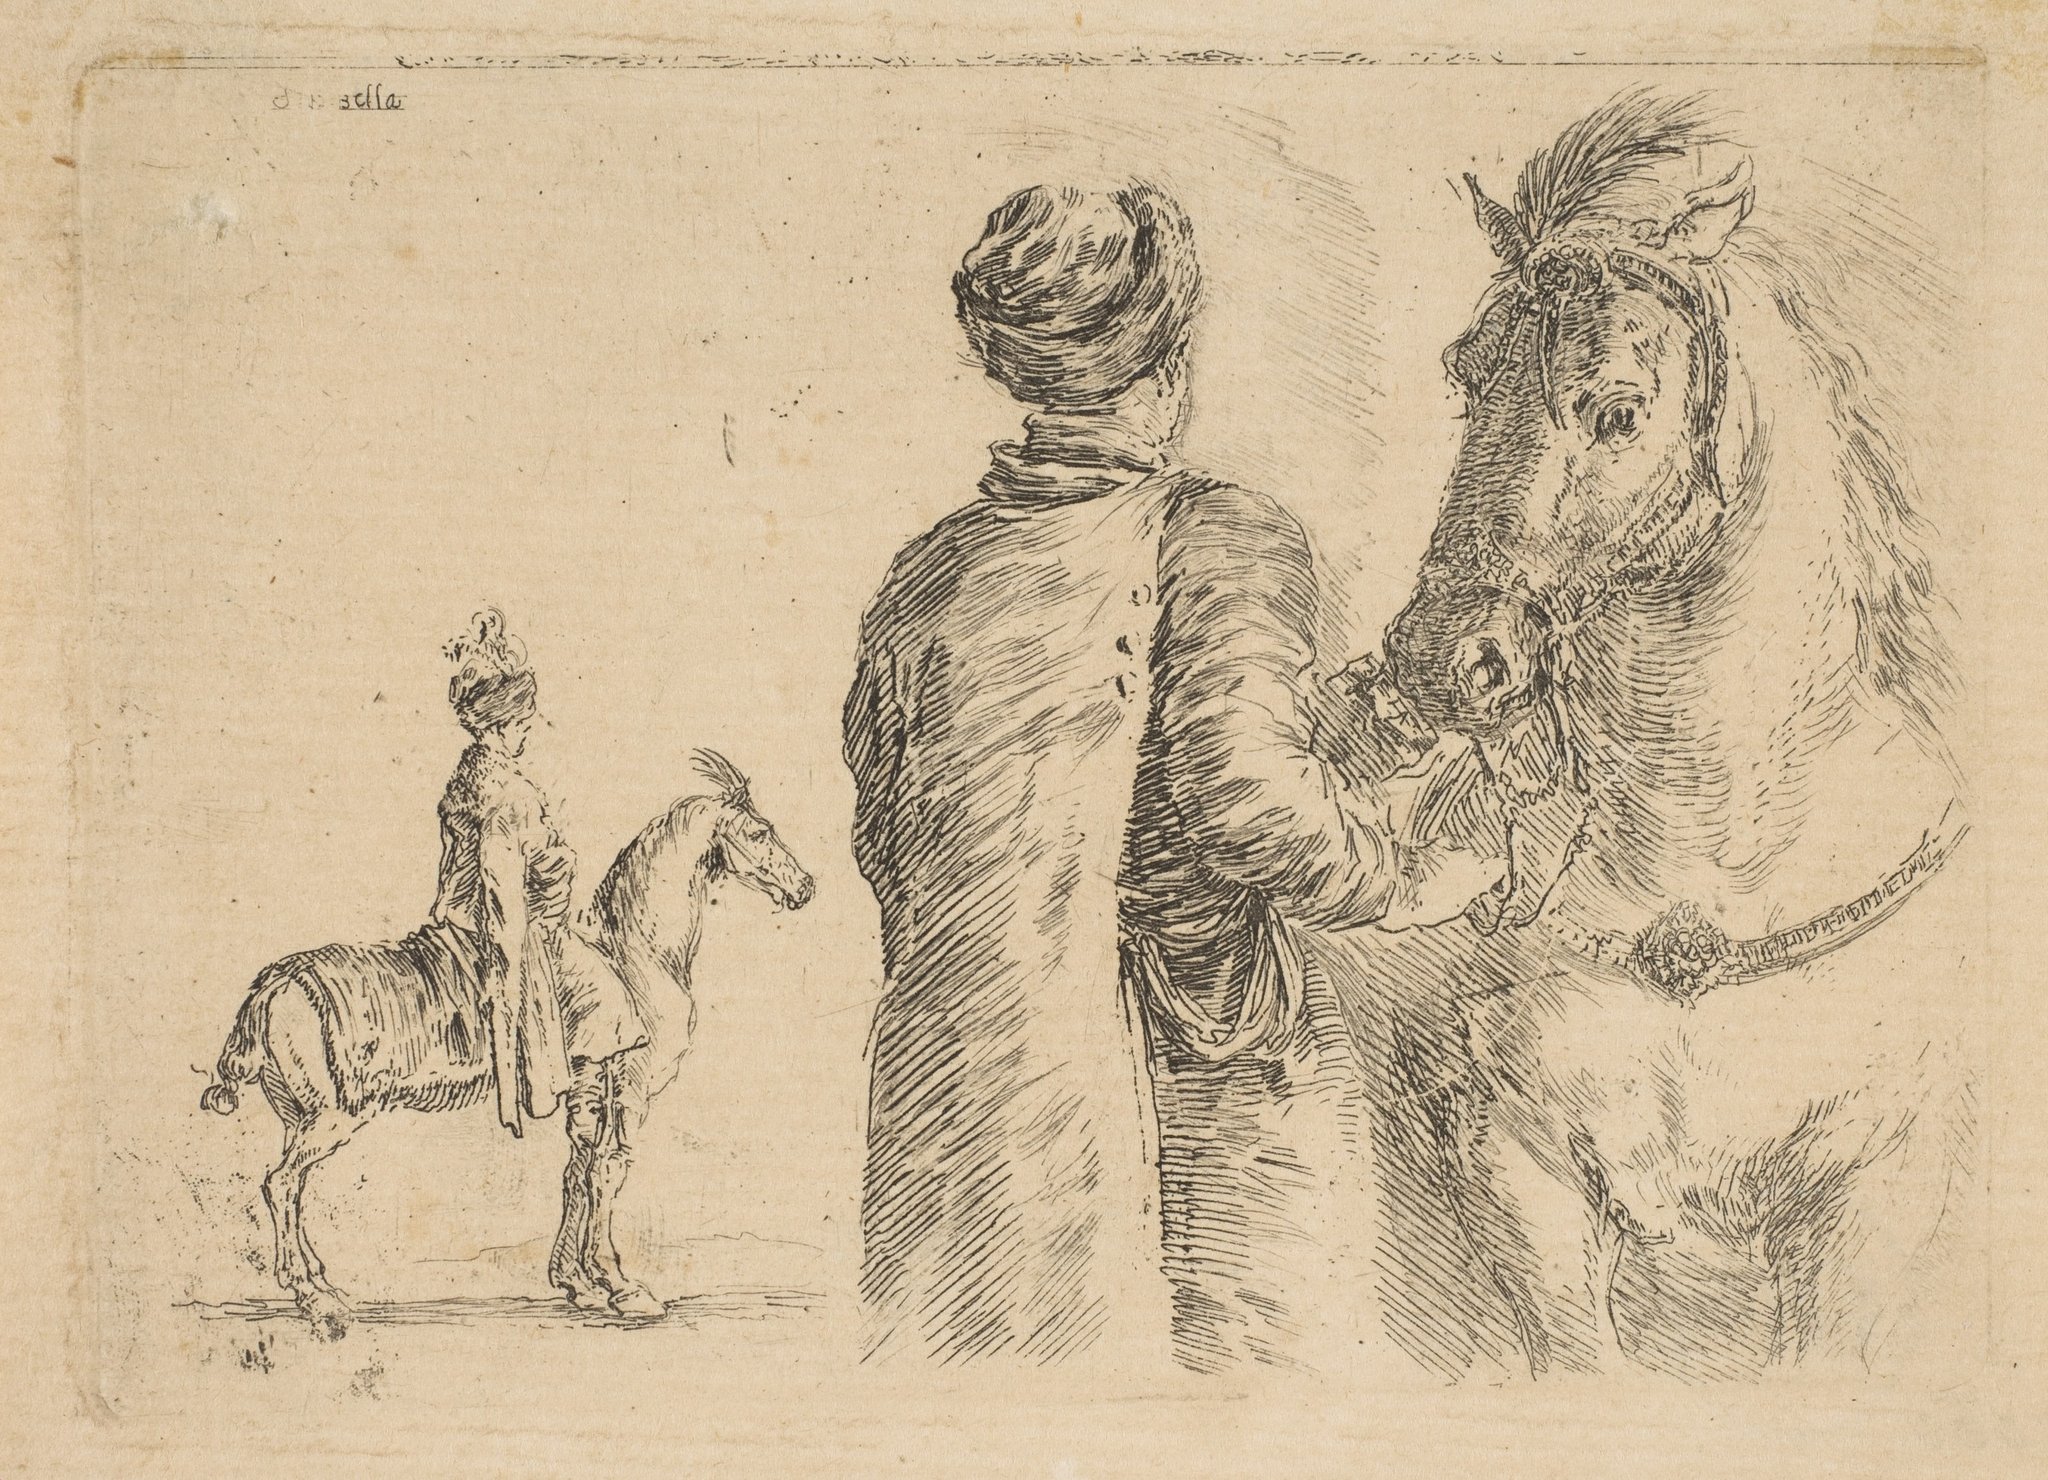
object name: print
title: A Polish groom, from the back, holding a horse by the bridle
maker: stefano della bella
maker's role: artist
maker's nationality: italian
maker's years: 1610-1664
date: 1662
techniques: etching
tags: men,horses